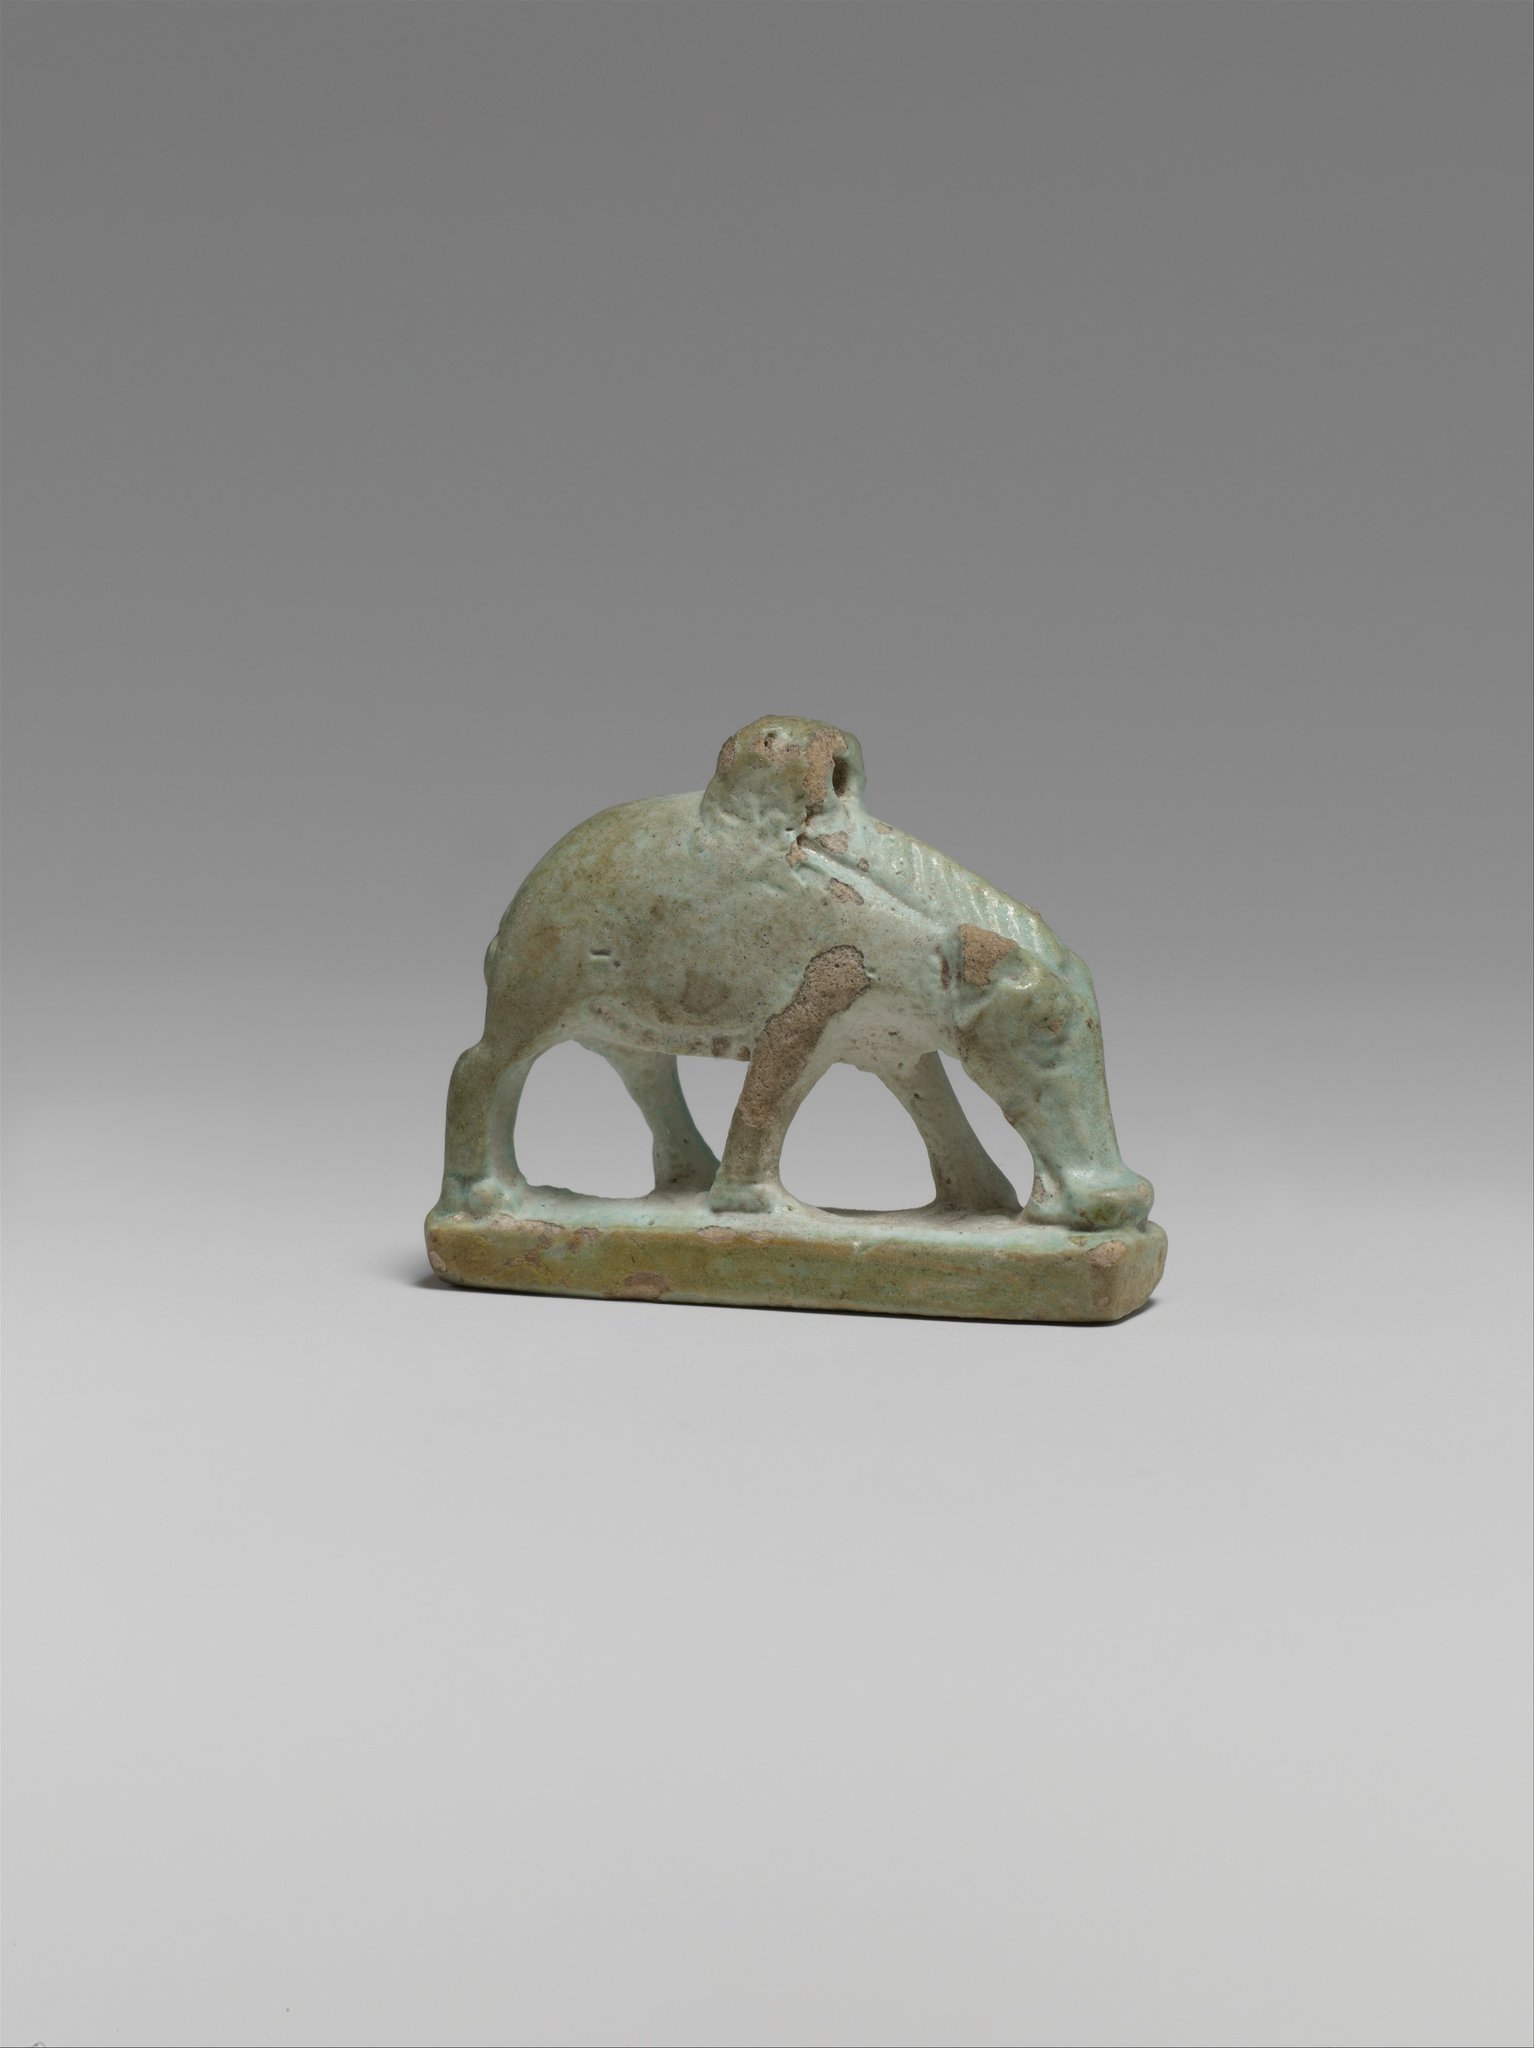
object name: sow amulet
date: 664-380 BCE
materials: faience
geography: egypt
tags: animals